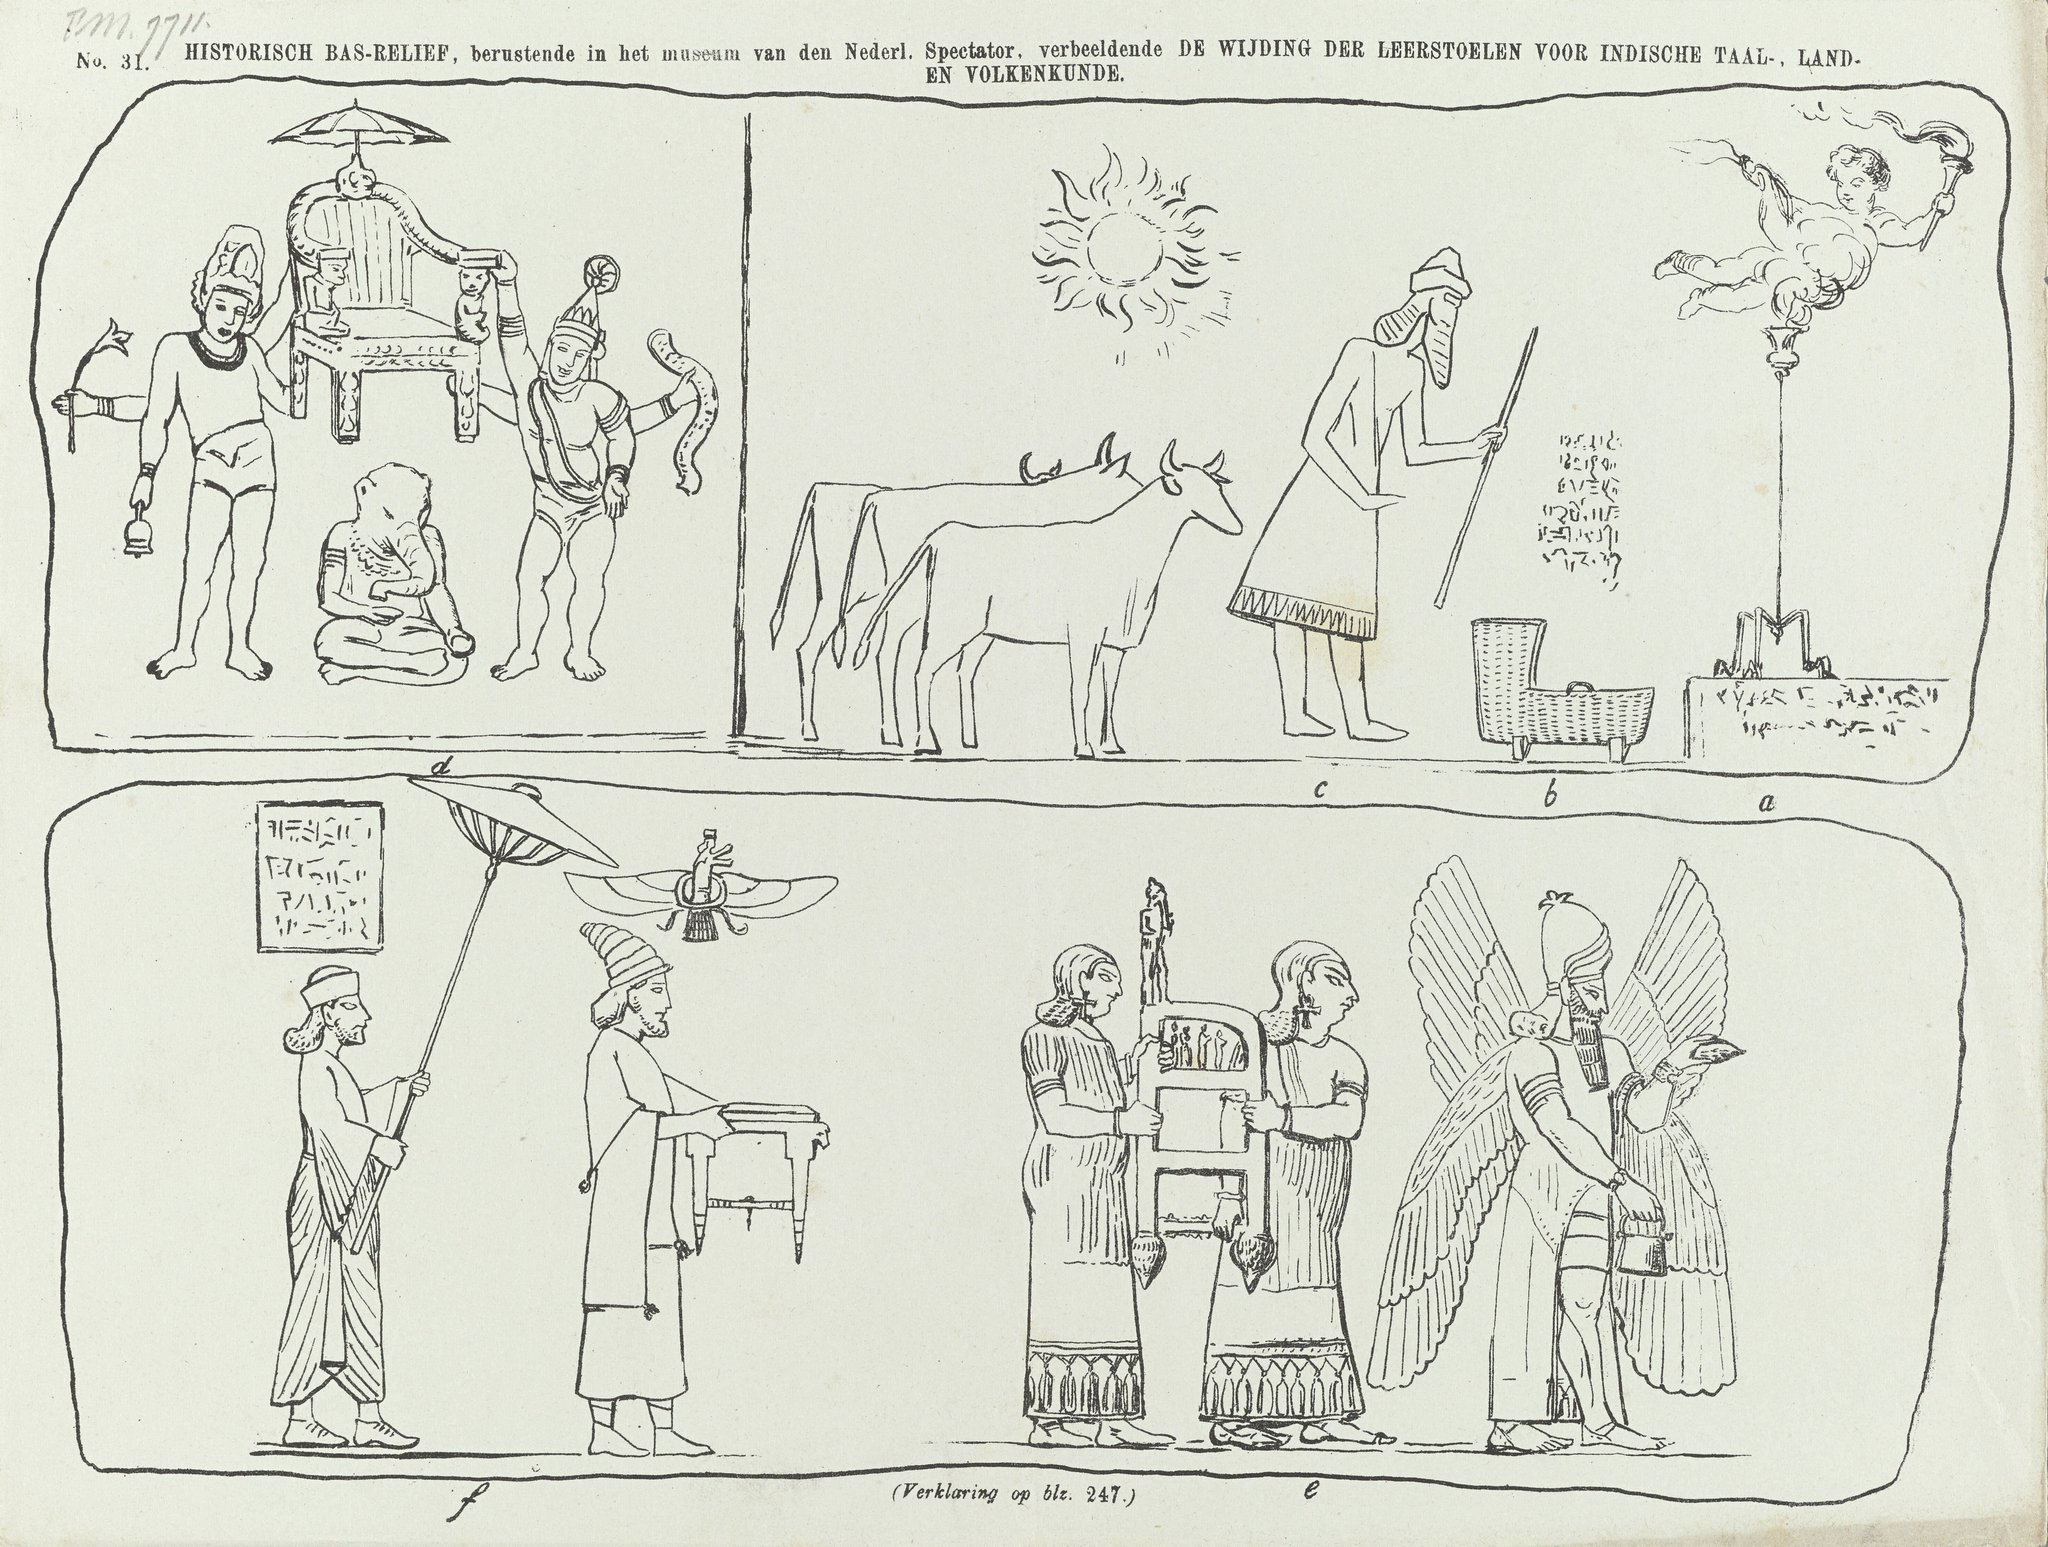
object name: cartoon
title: Spotprent op het wetsontwerp voor hoger onderwijs in Indische taal-, land- en volkenkunde, 1864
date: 1864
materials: paper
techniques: lithograph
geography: arnhem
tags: decorating 'en relief', appliquéing, dutch east indies, the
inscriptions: collector's mark: Lugt 2228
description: Spotprent op het wetsontwerp voor hoger onderwijs in Indische taal-, land- en volkenkunde. Drie voorstellingen in de vorm van bas-reliëfs waarin drie stoelen zijn verwerkt. Plaat verschenen bij het weekblad De Nederlandsche Spectator, nr. 31, 30 juli 1864.